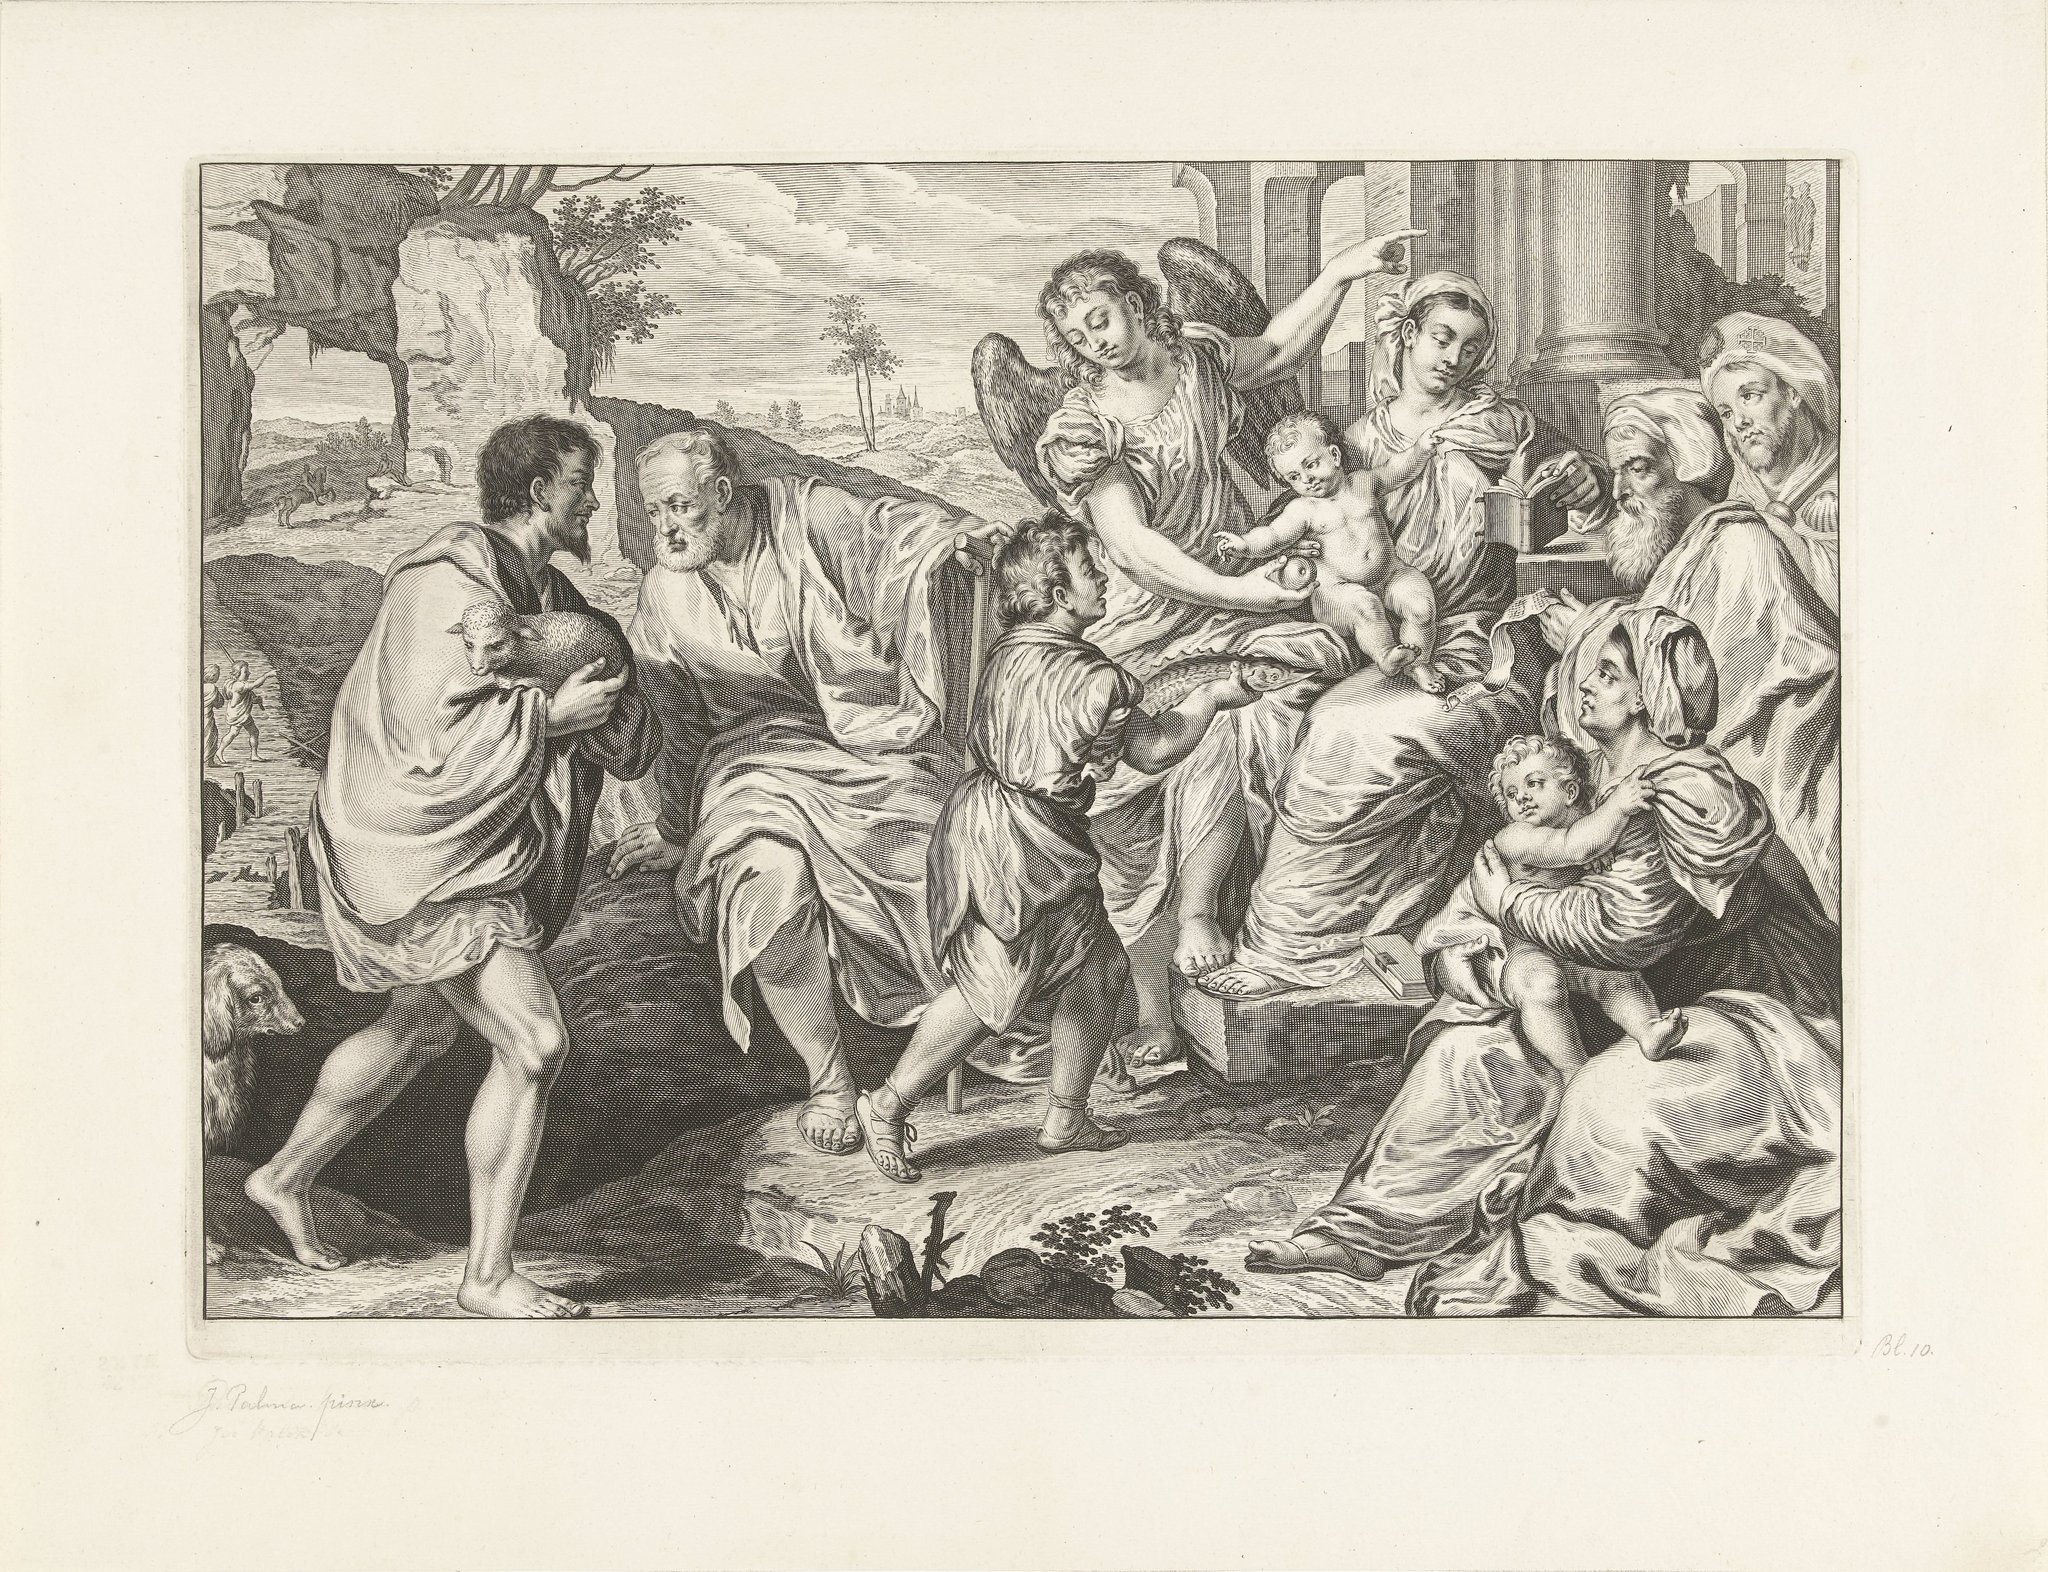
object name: print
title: De heilige familie in gezelschap van anderen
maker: jeremias falck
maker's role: print maker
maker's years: 1609-1677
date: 1655-1677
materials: paper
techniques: engraving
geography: amsterdam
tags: holy family with john the baptist (as child)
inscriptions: collector's mark: Lugt 2165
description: In een bergachtig landschap zit Maria met Christus op haar schoot. Ze leest in een boek, terwijl een engel Christus een appel aanreikt en Tobias hem een vis toont. Jozef praat met een man met een lam in zijn armen en Elisabet heeft haar zoon Johannes op schoot. Achter Elisabet staan twee pelgrims.